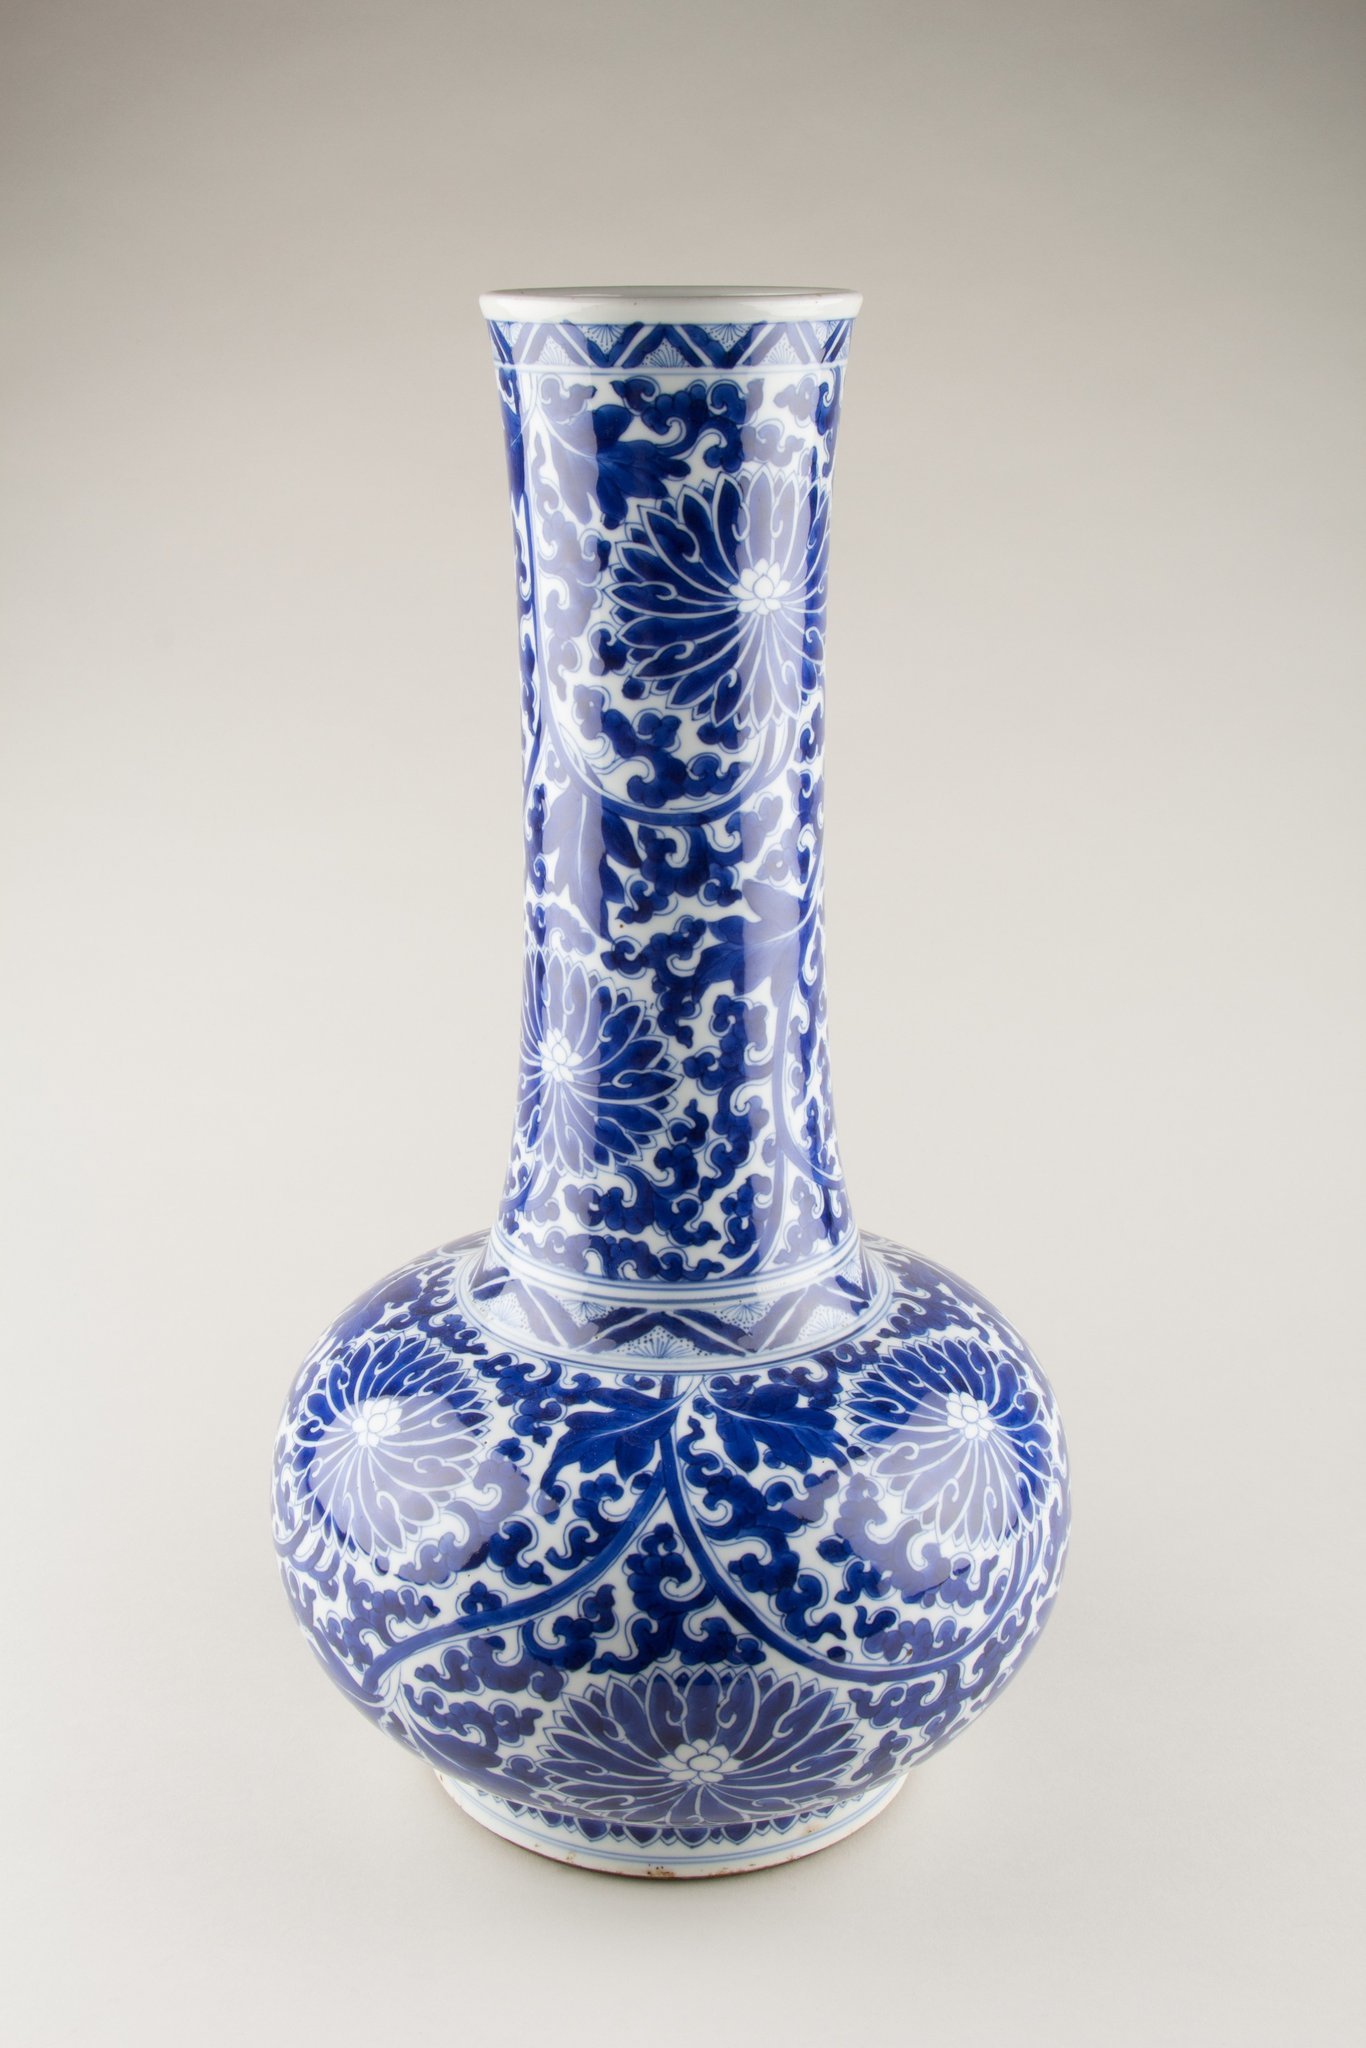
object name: bottle vase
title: Bottle vase with floral scrolls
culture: chinese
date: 1667-1733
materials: cobalt, porcelain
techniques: painting, underglaze